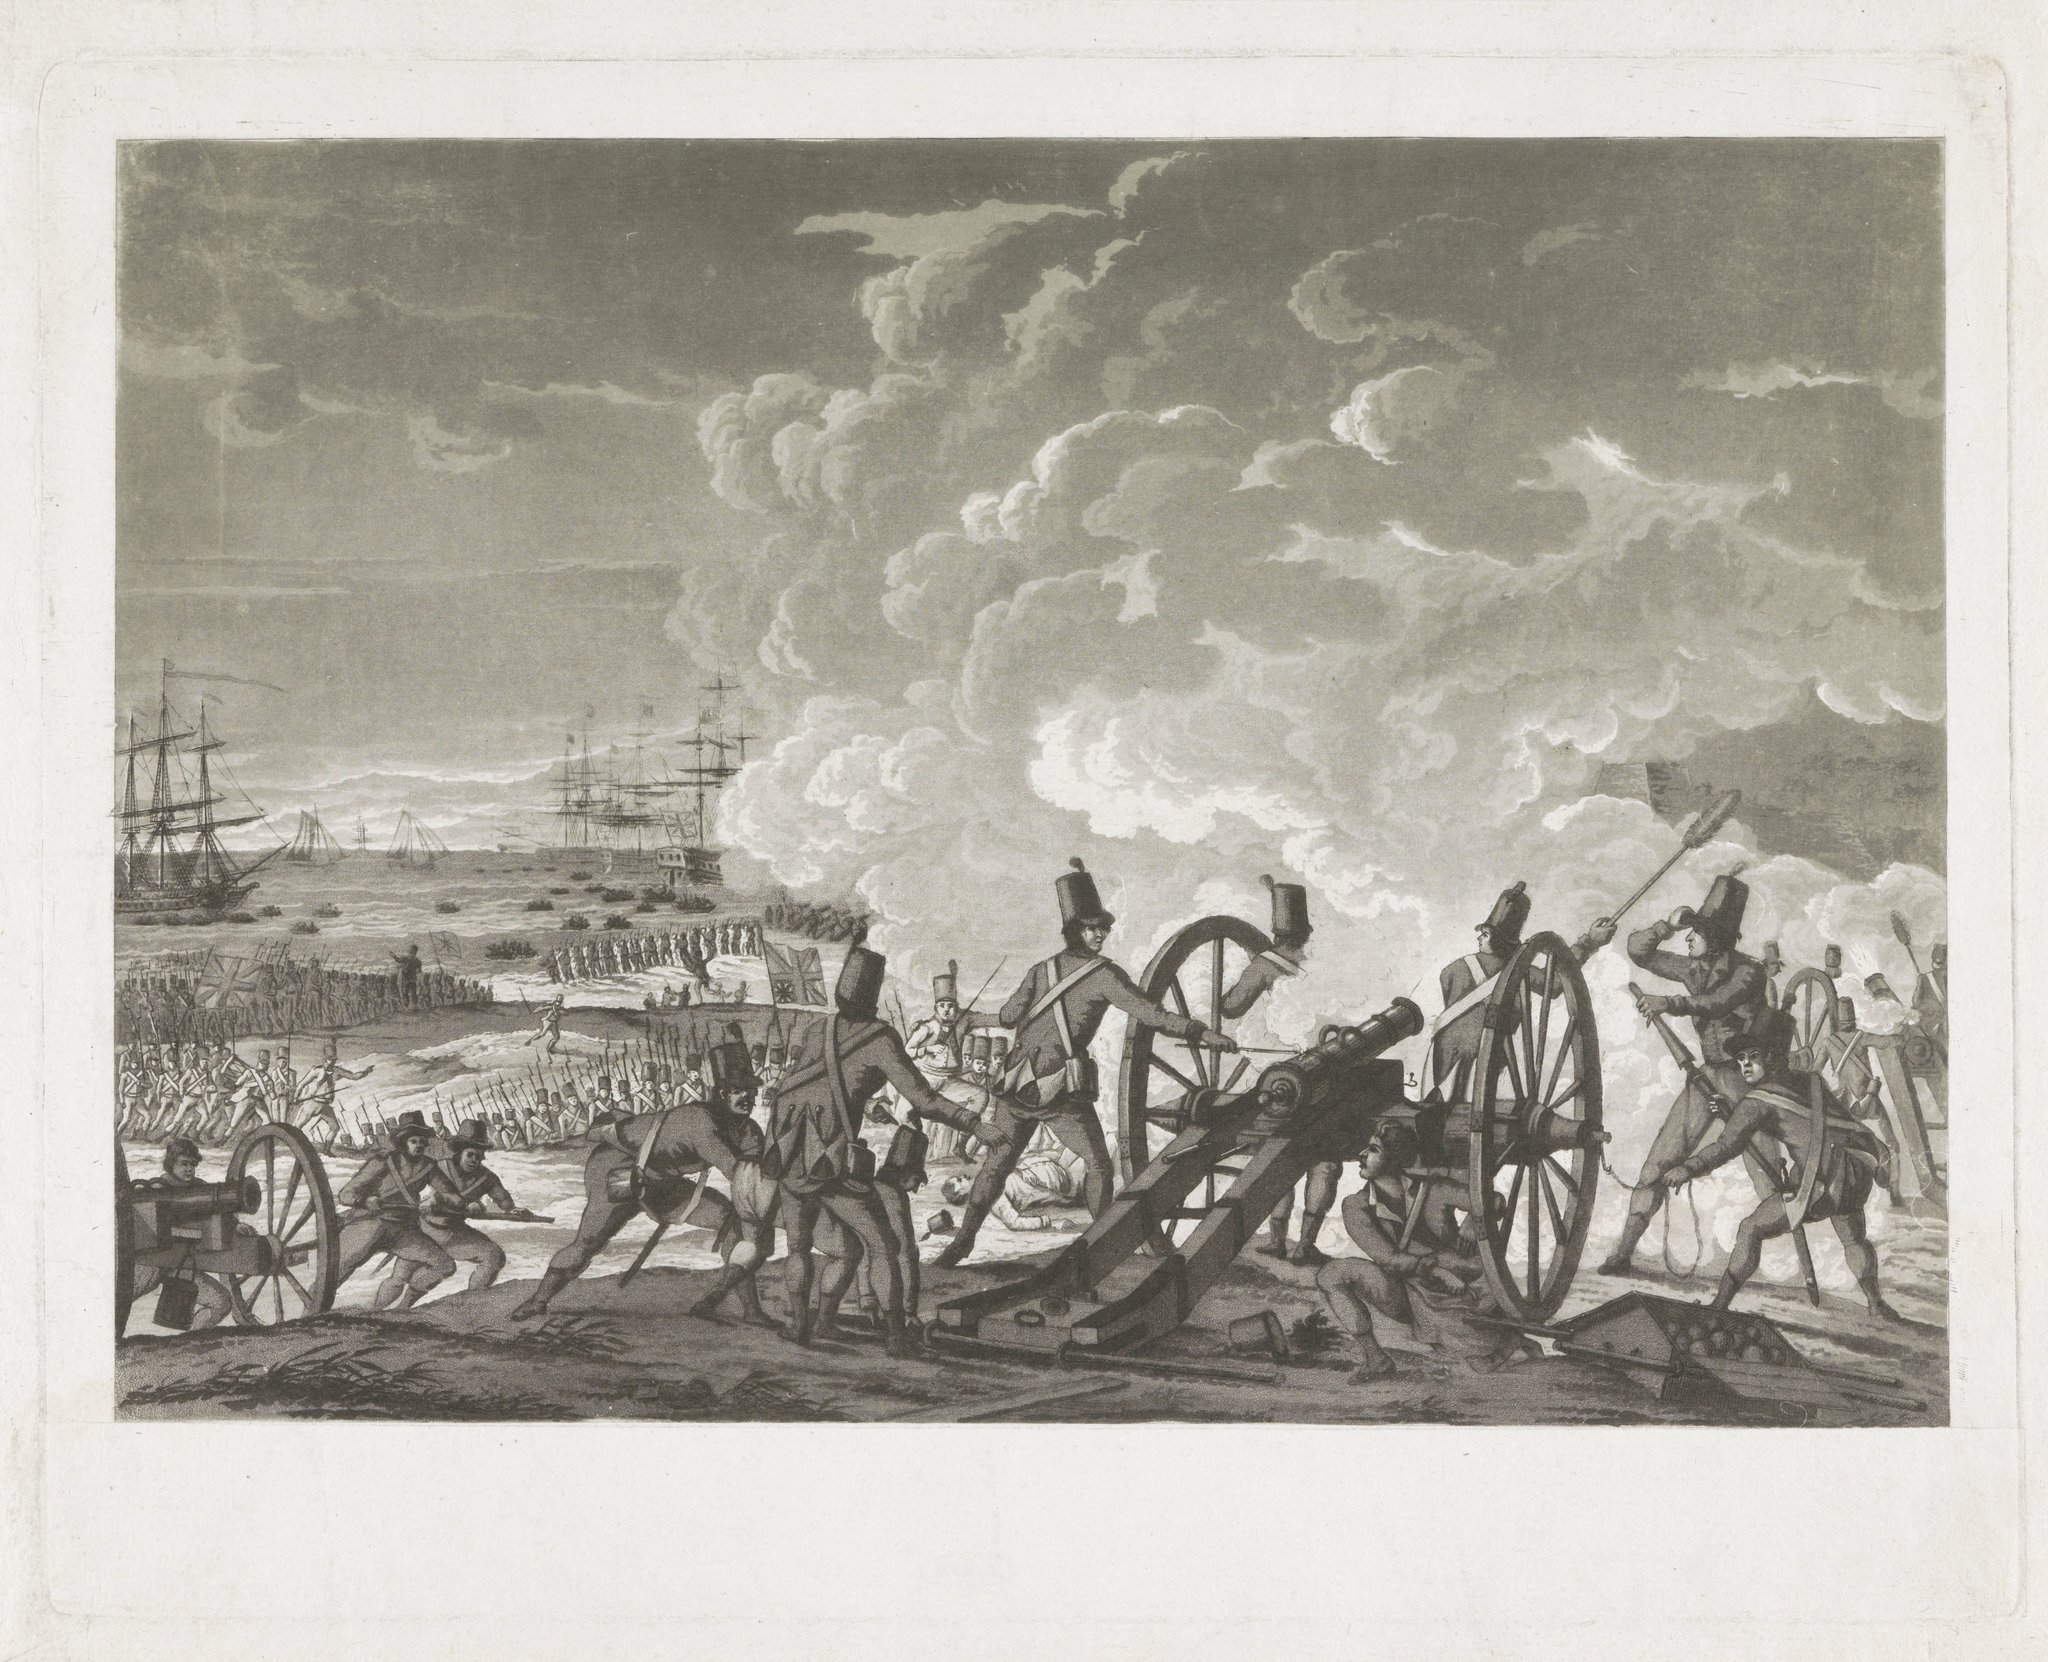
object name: print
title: Landing van de Britten op Walcheren, 1809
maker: a. lutz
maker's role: print maker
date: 1809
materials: paper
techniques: aquatint, etching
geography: netherlands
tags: (military) attack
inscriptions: collector's mark: Lugt 2228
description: Landing van Britse troepen op de kust van Walcheren. Op de voorgrond wordt met een kanon geschoten op Fort den Haak, 30 juli 1809. Zie ook de pendant.